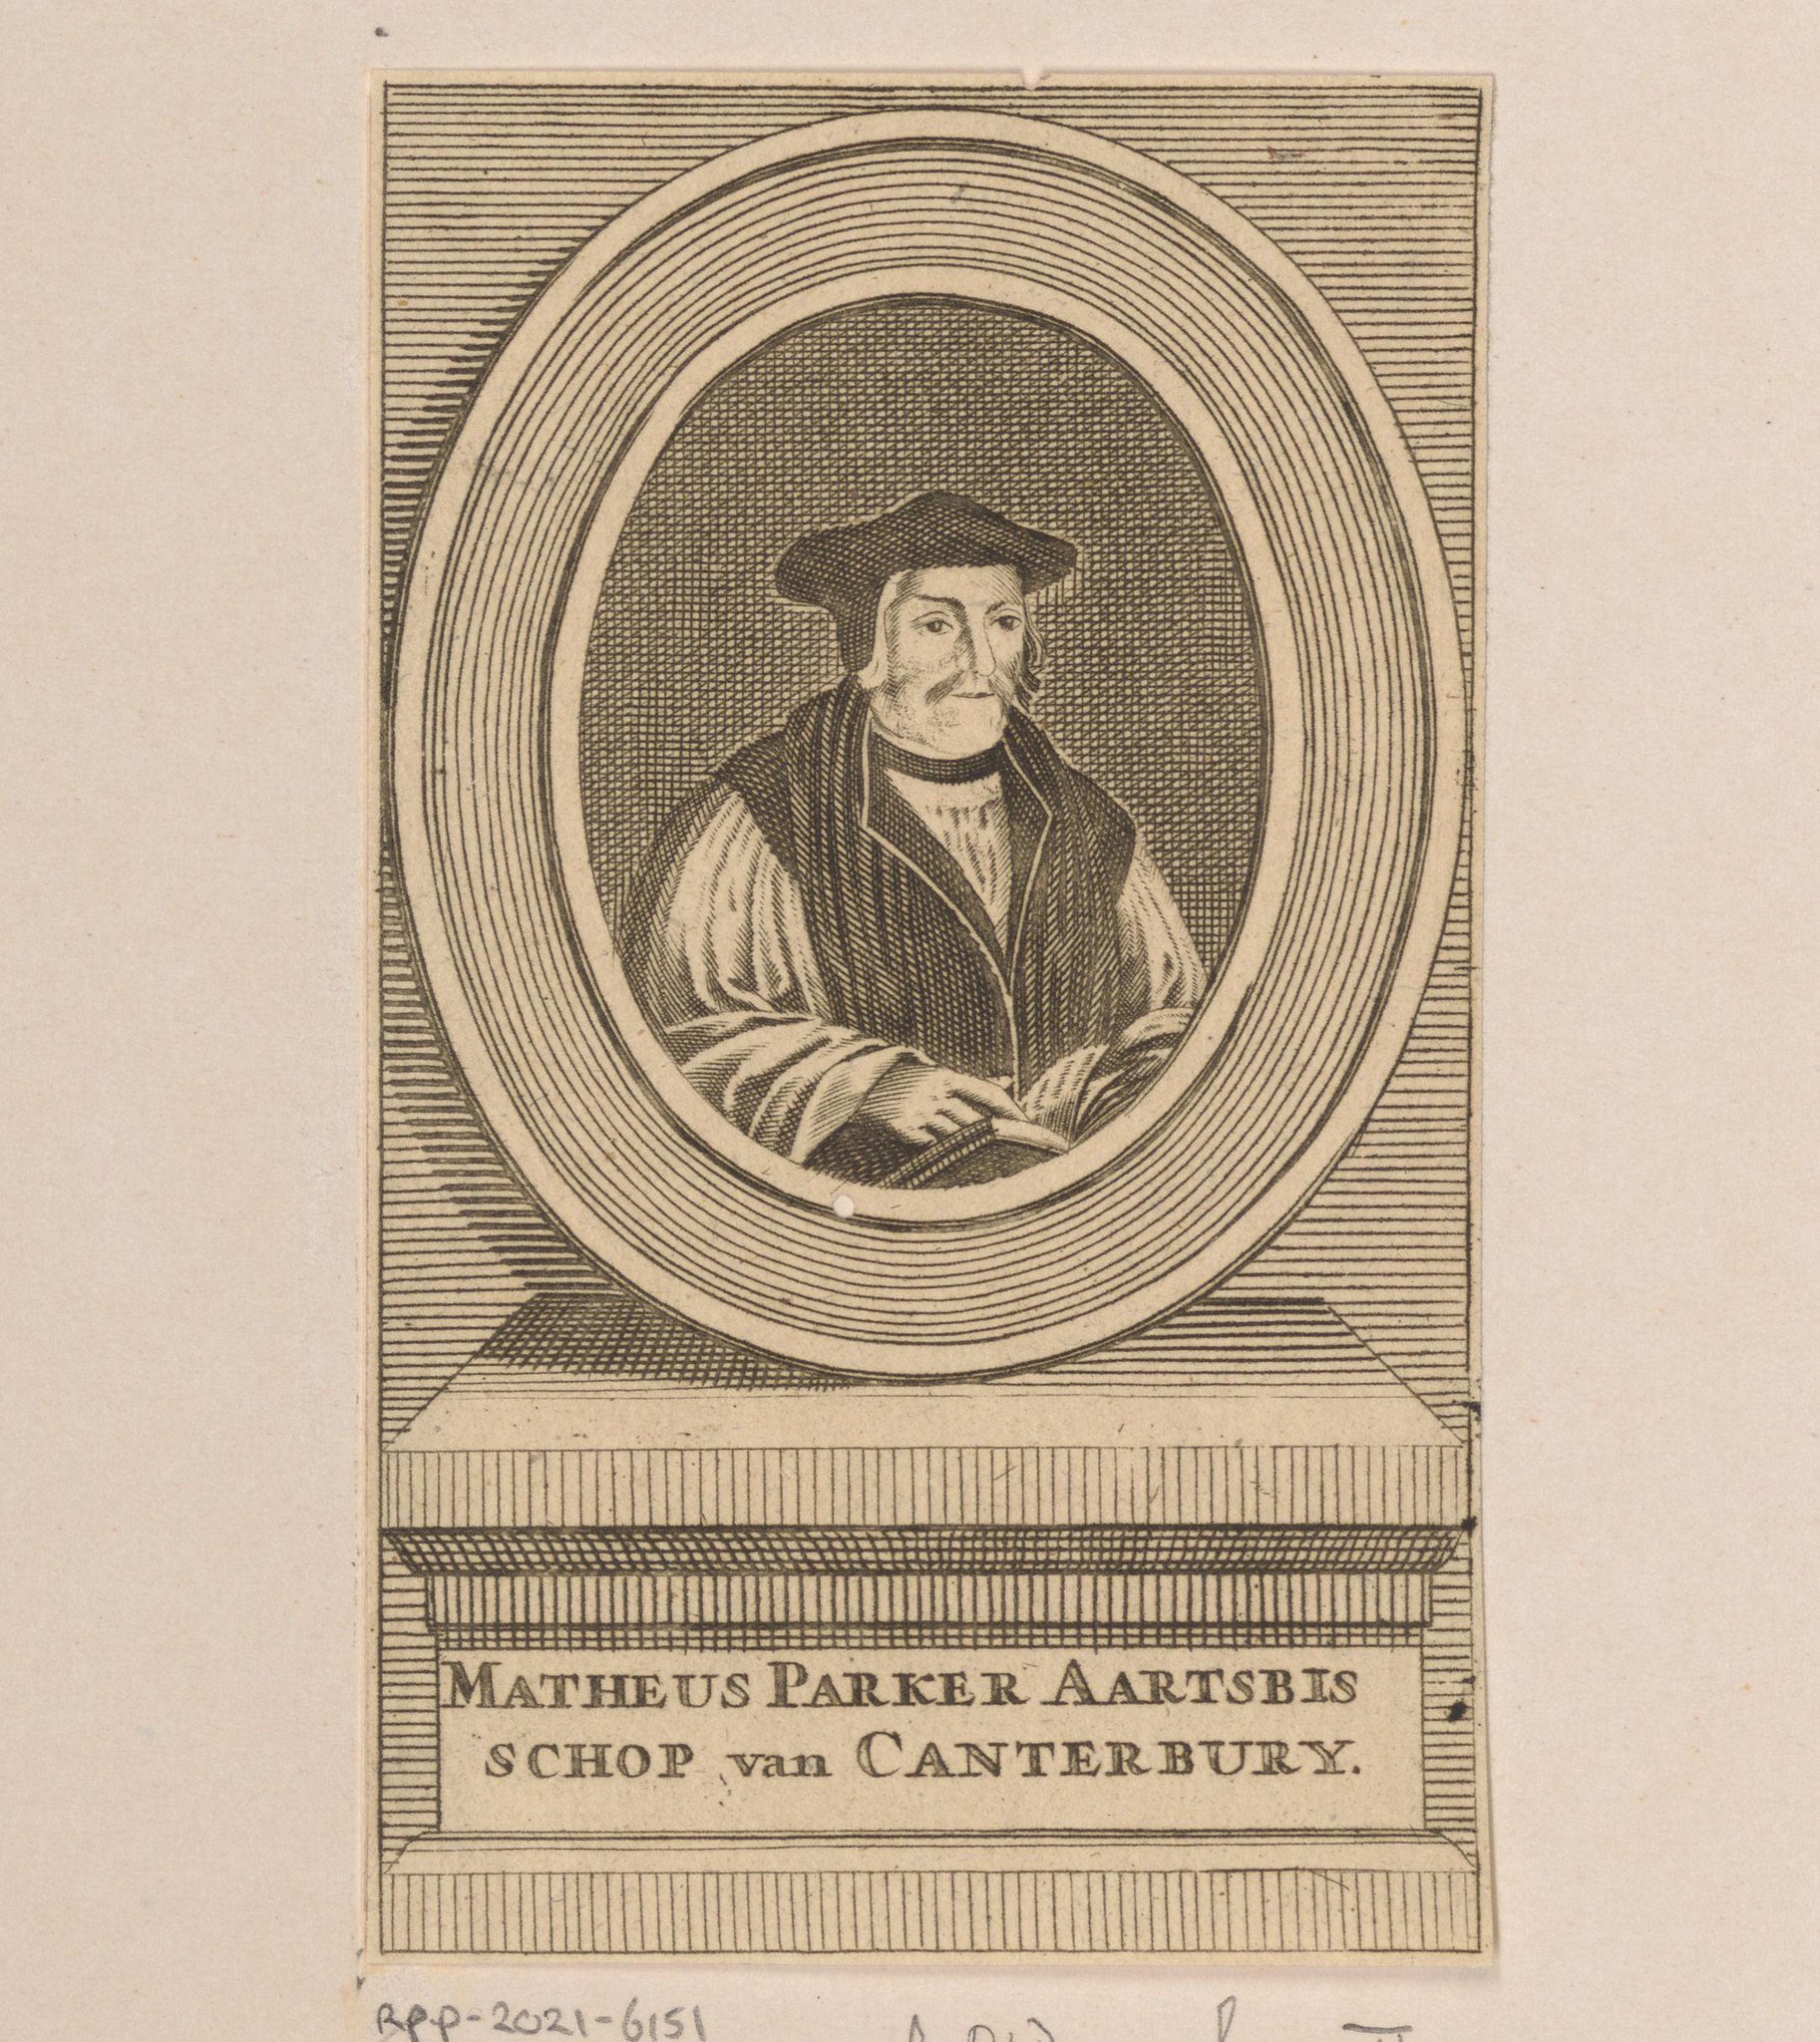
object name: book illustration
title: Portret van Mathew Parker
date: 1690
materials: paper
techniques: engraving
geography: amsterdam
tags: archbishop, bishop, etc. (roman catholic), adult man, historical persons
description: Prent uit: Burnet, Gilbert. Kort-begryp van de historie der reformatie van de Kerk van Engeland. Amsterdam: weduwe Steven Swart, 1690.